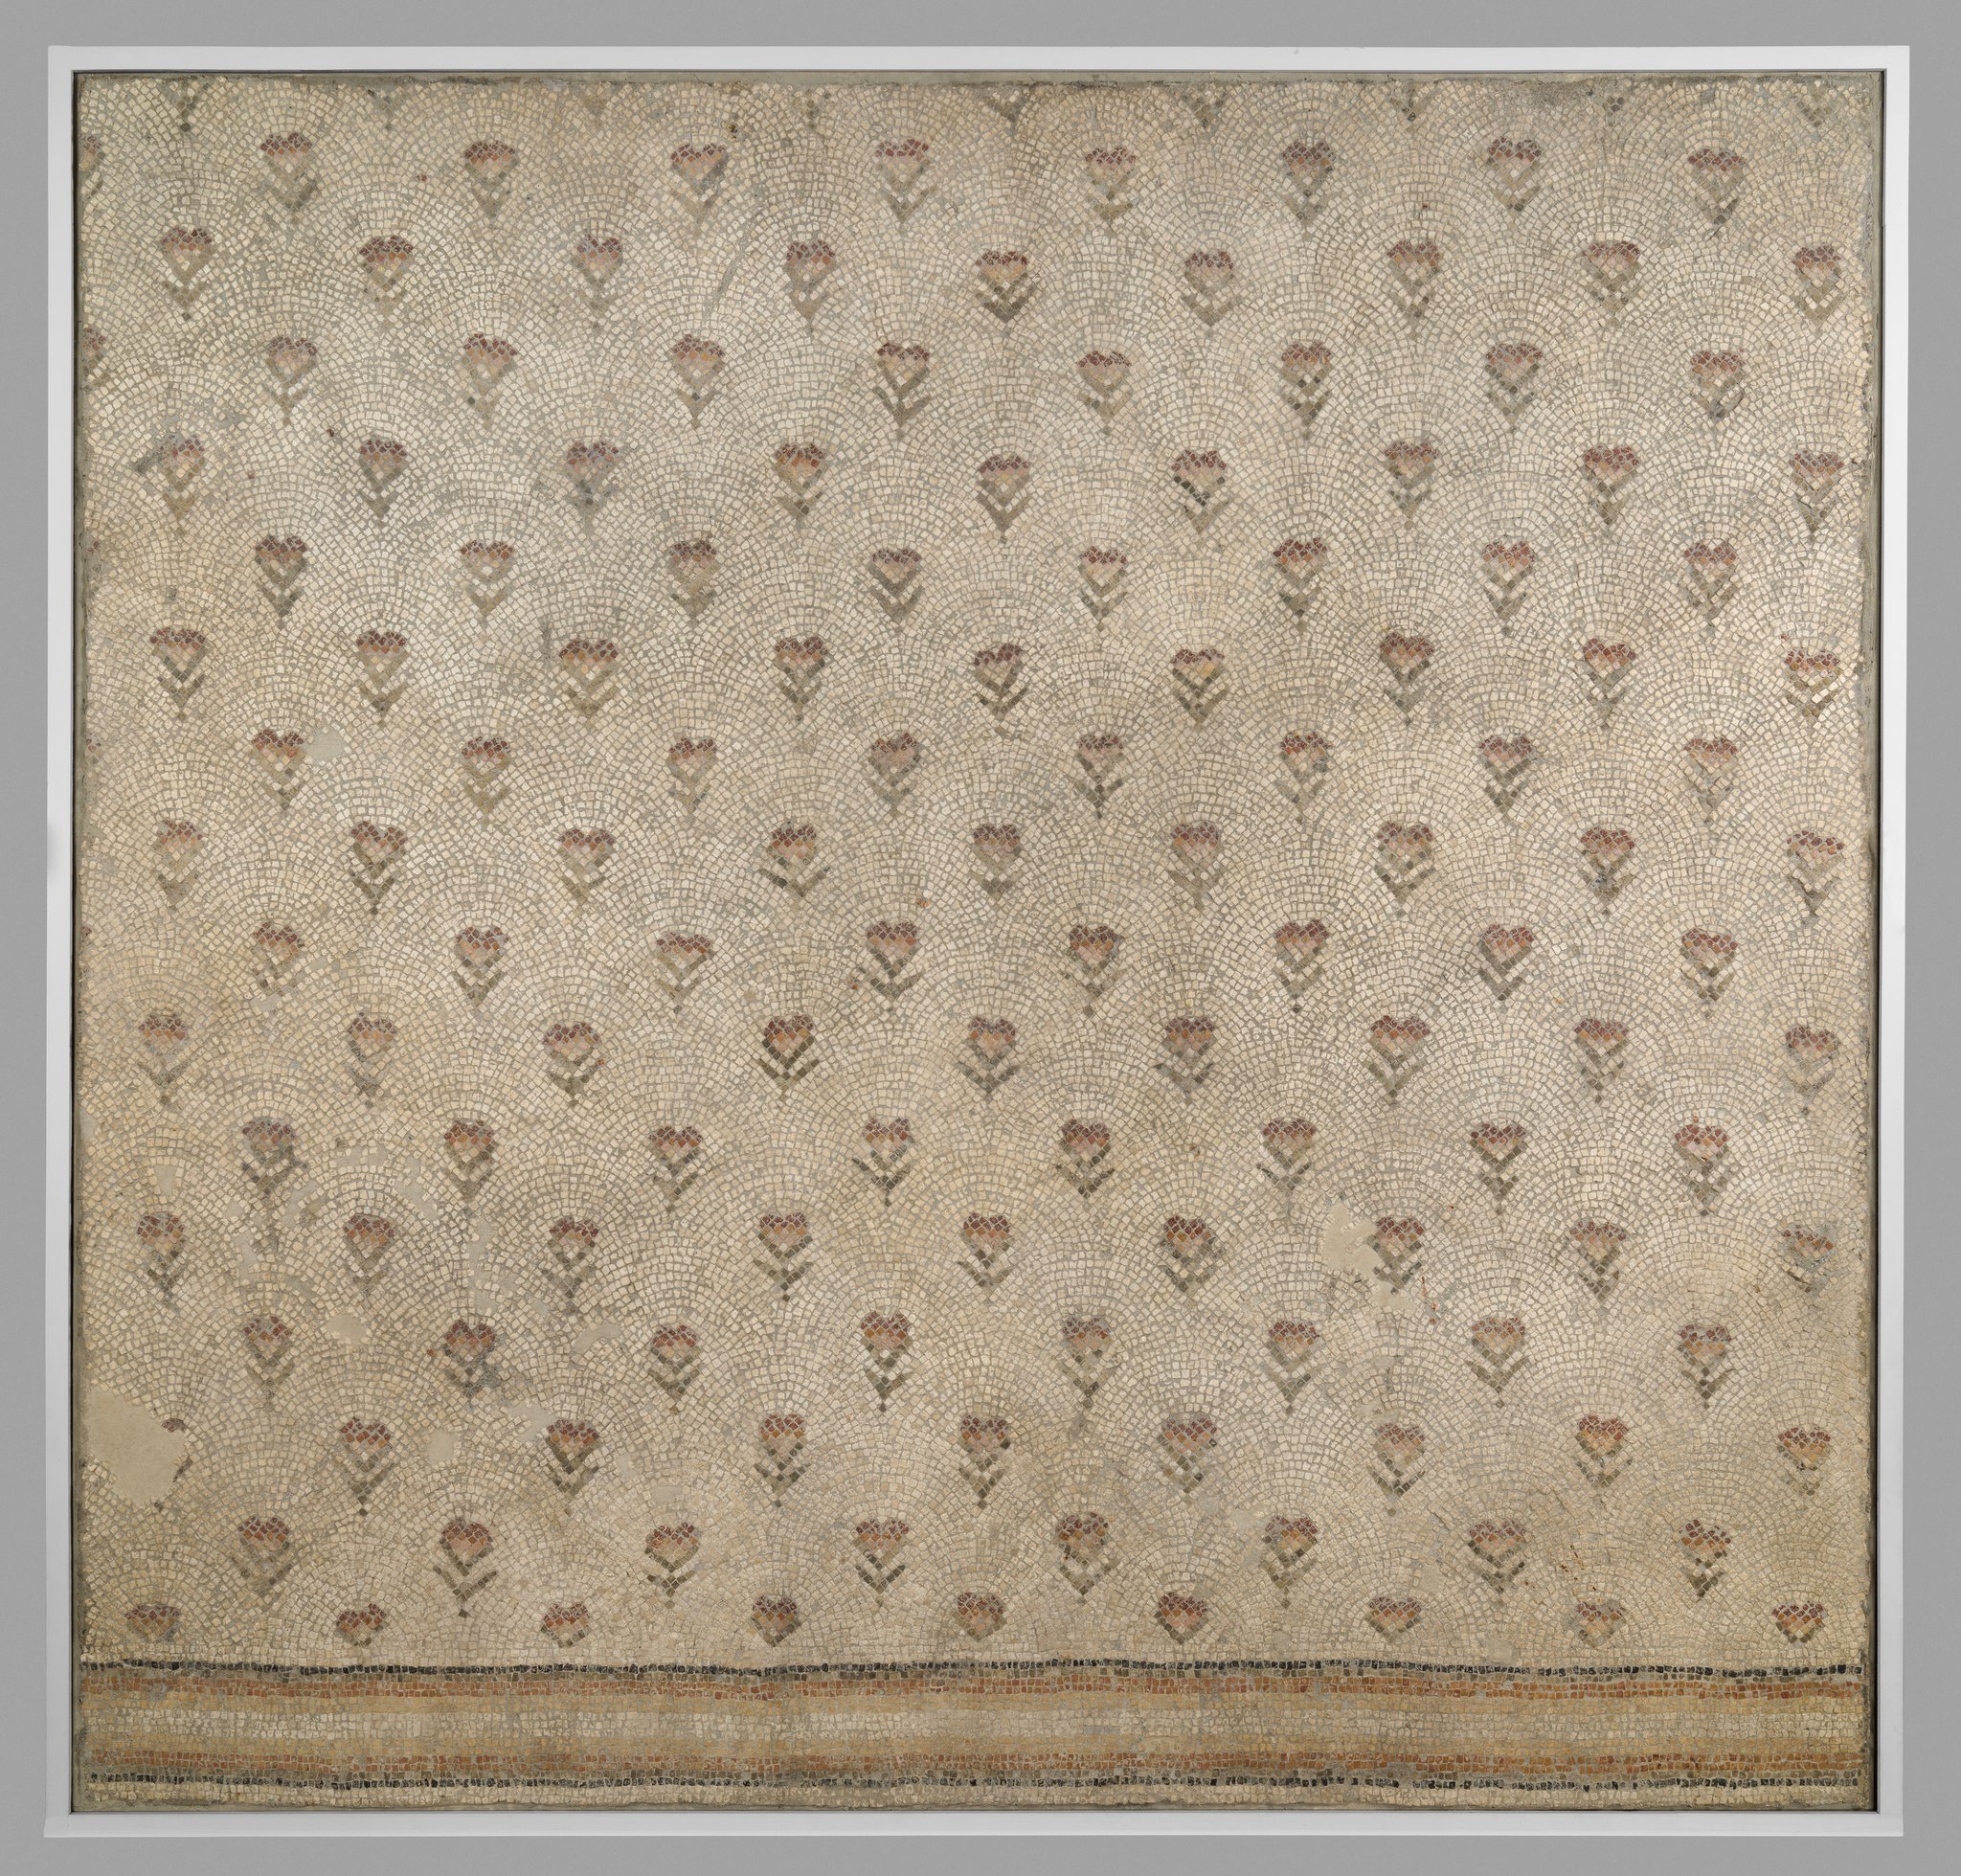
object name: mosaic fragment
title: Section of a Marble Mosaic Bathhouse Floor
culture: byzantine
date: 537-538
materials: marble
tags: flowers